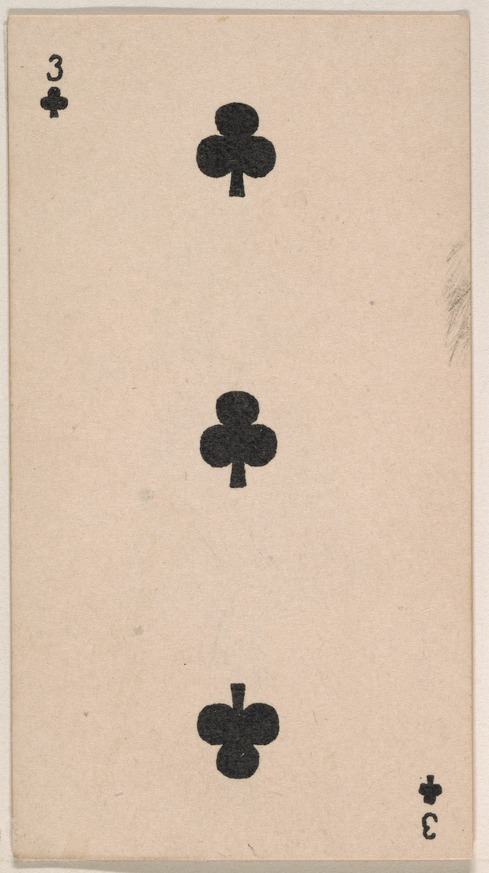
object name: print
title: Three of Clubs, from the Transparent Playing Cards series (N220) issued by Kinney Bros.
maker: kinney brothers tobacco company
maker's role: publisher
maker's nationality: american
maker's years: 1869-2011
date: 1888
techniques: color lithograph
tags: playing cards